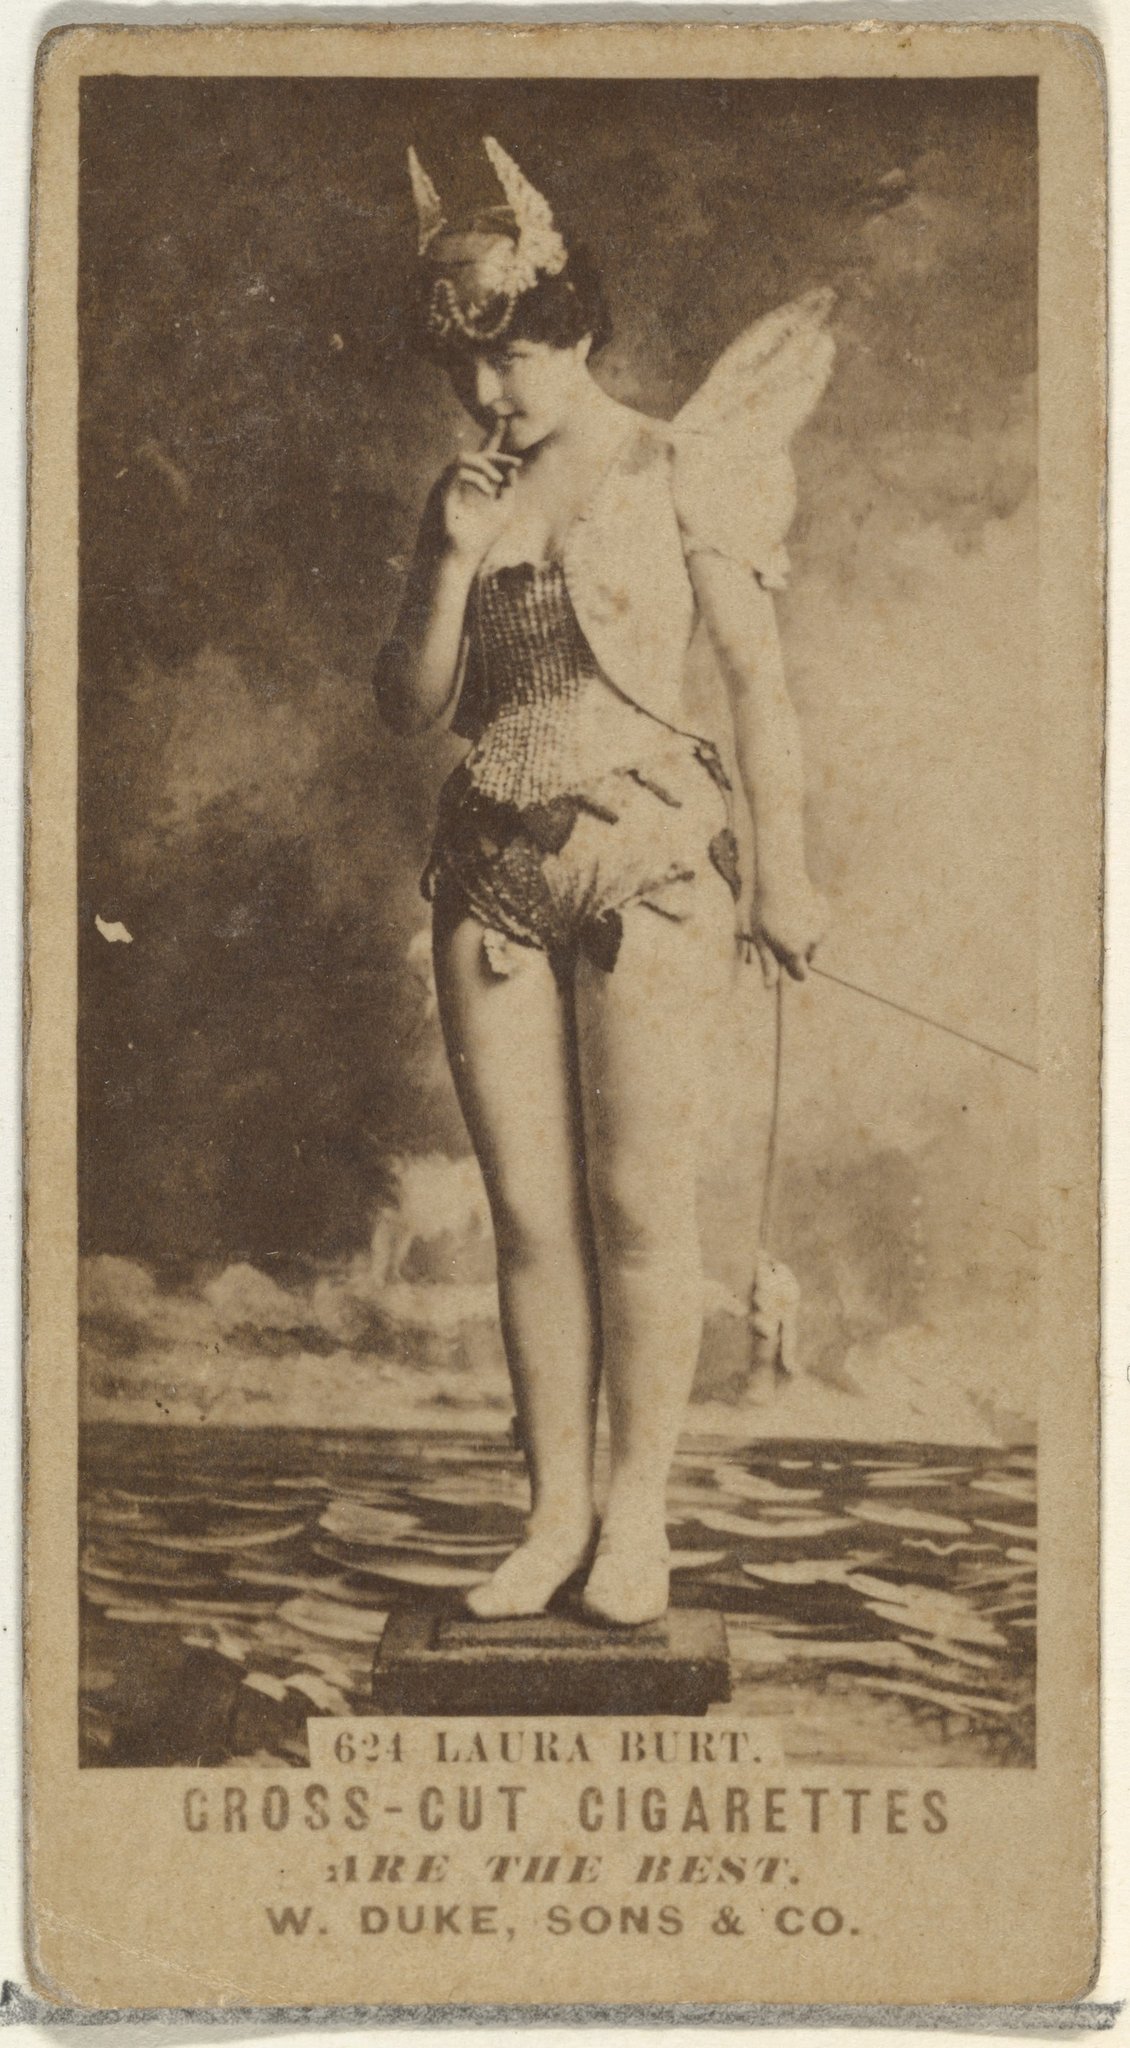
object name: photograph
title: Card Number 624, Laura Burt, from the Actors and Actresses series (N145-3) issued by Duke Sons & Co. to promote Cross Cut Cigarettes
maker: w. duke, sons & co.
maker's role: publisher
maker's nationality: american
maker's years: 1870-1920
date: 1880-1889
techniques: albumen silver print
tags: women,actresses